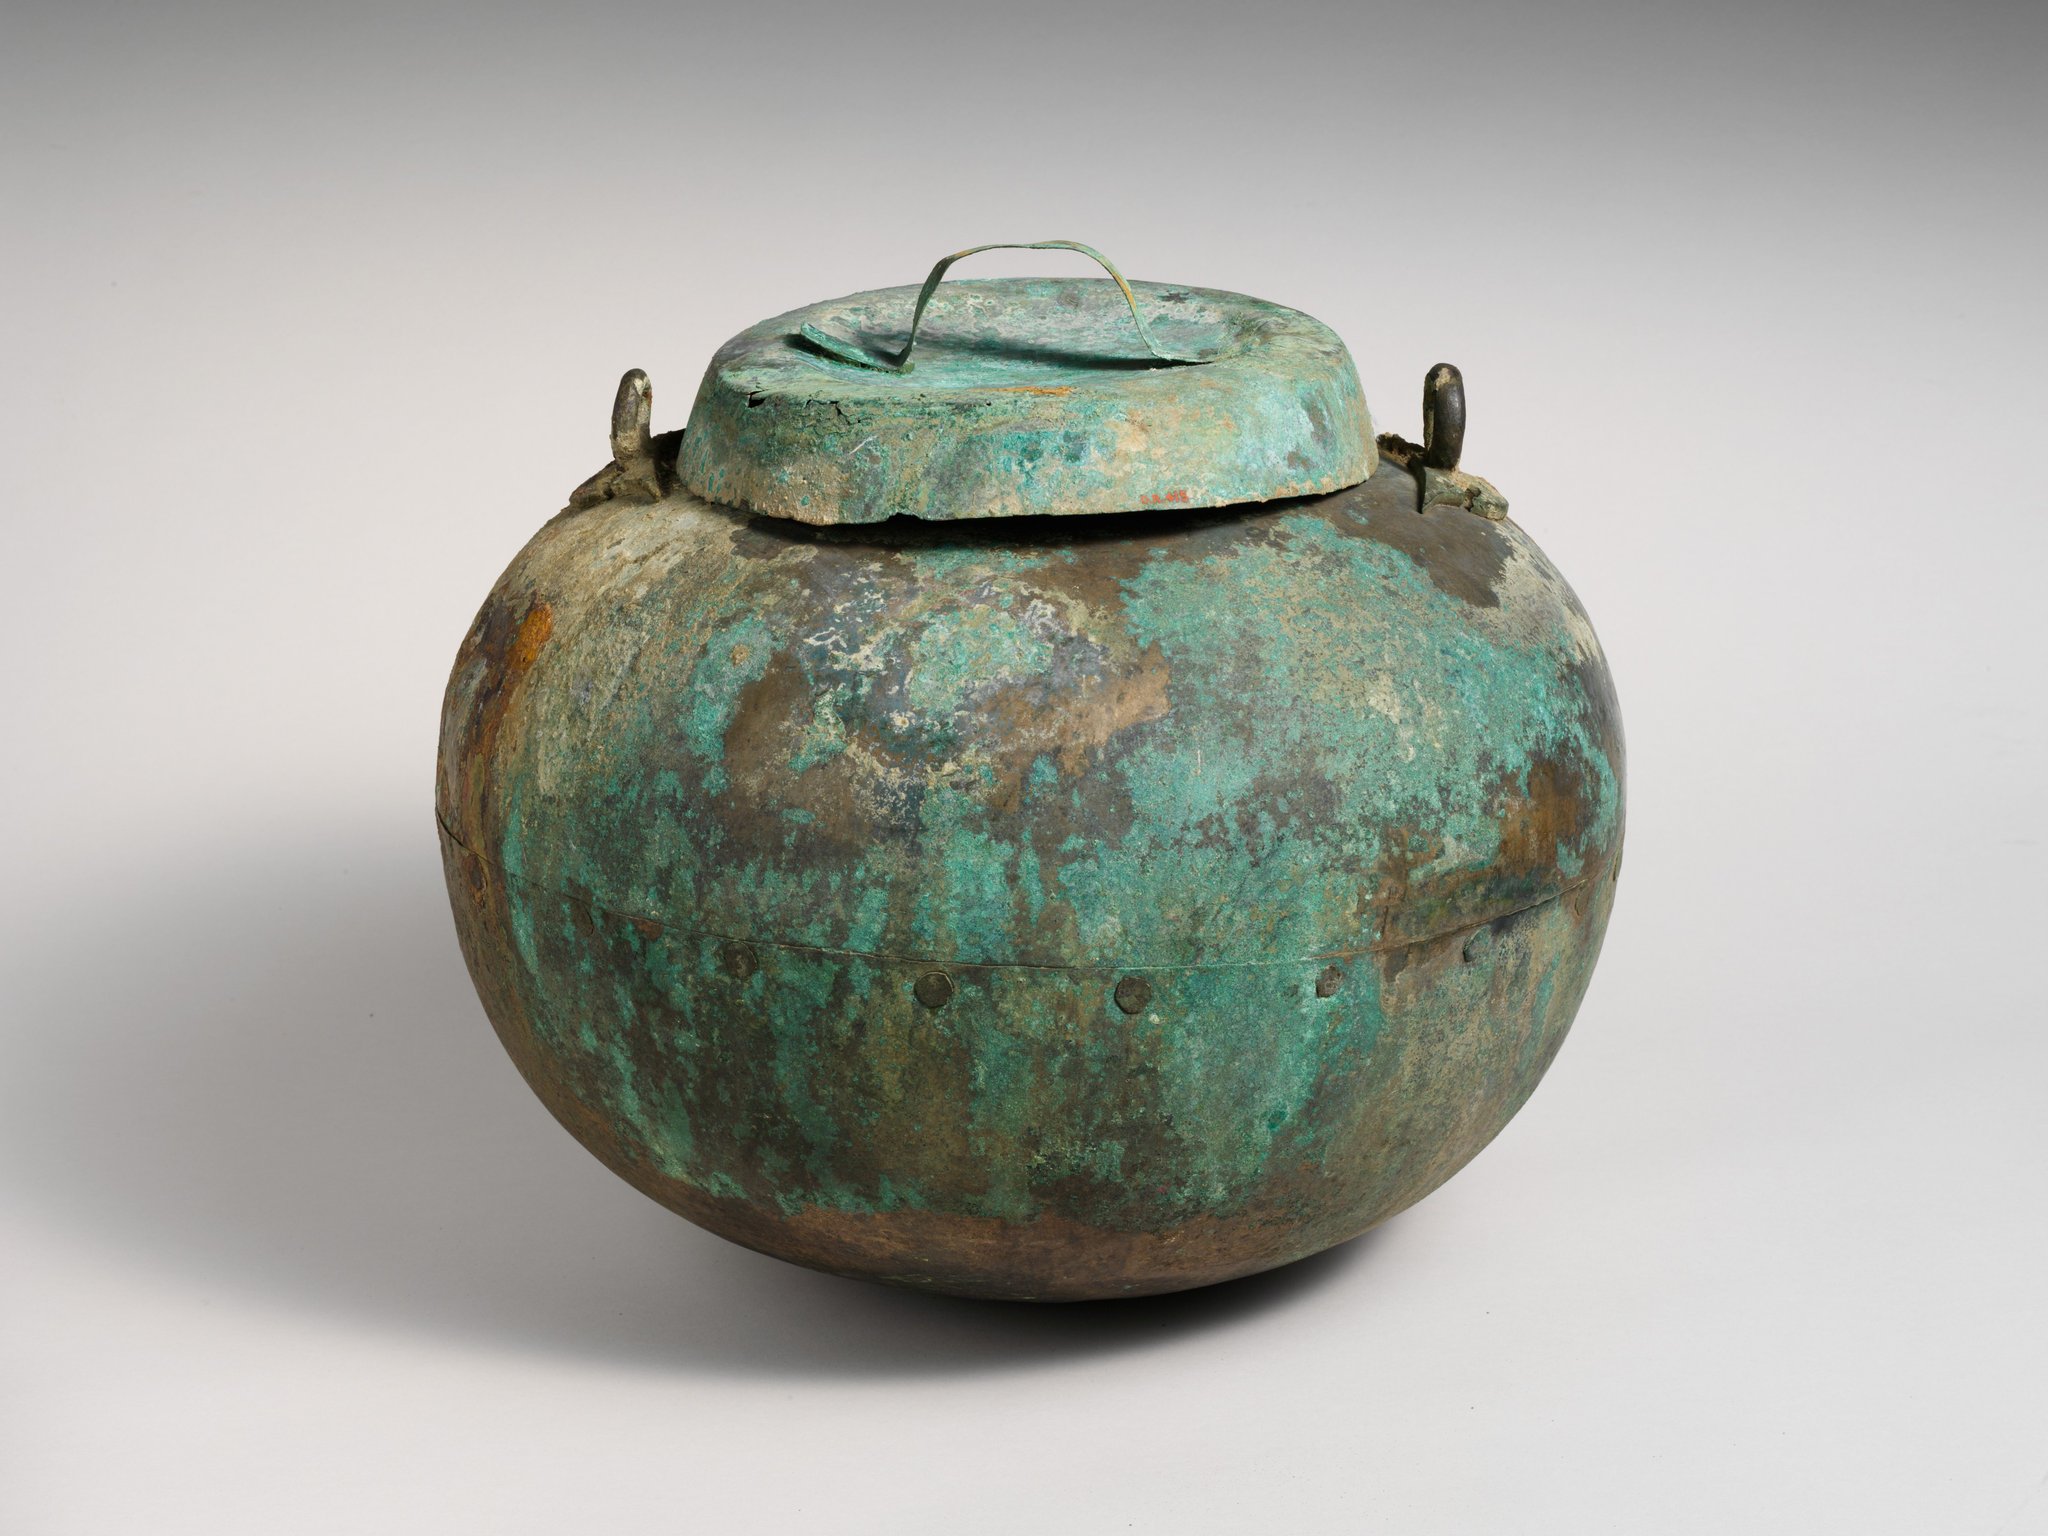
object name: cauldron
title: Bronze cauldron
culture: etruscan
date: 550 BCE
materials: bronze